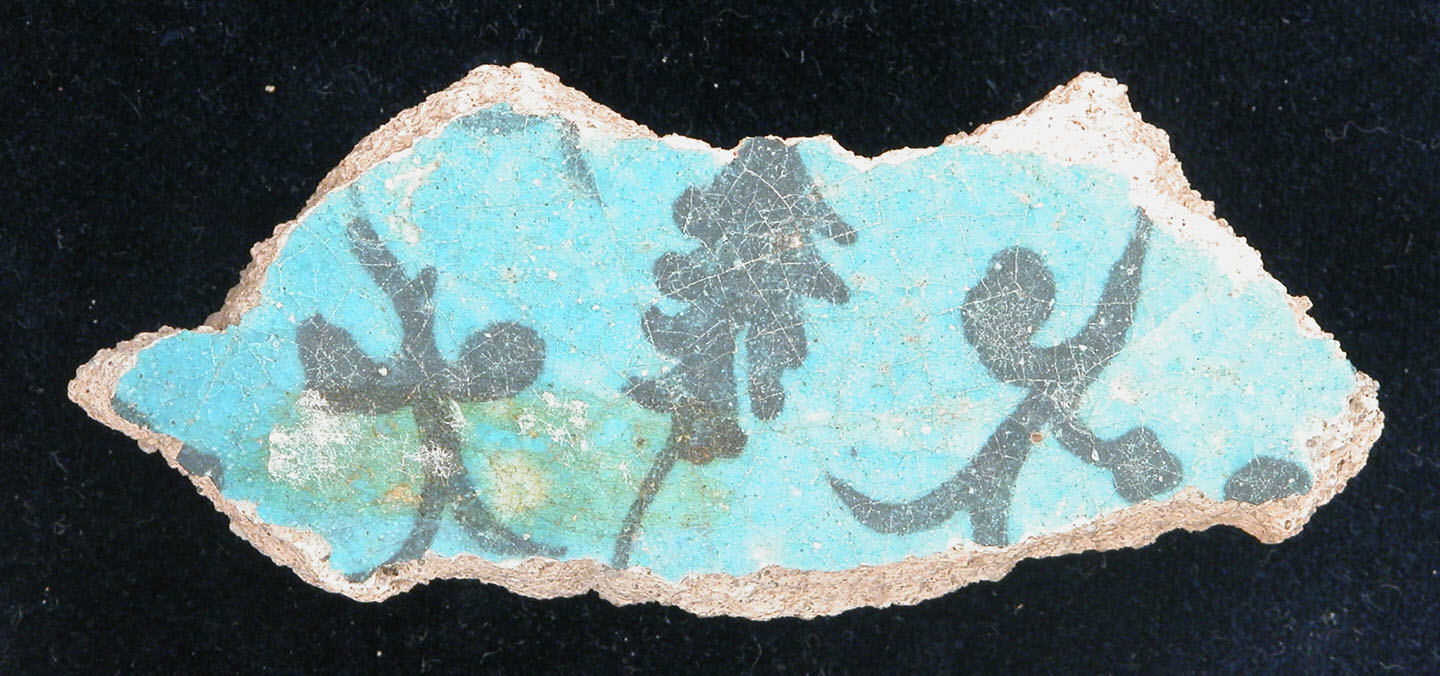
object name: fragment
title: Ceramic Fragment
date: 1101-1300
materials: stonepaste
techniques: painting, underglaze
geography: saudi arabia